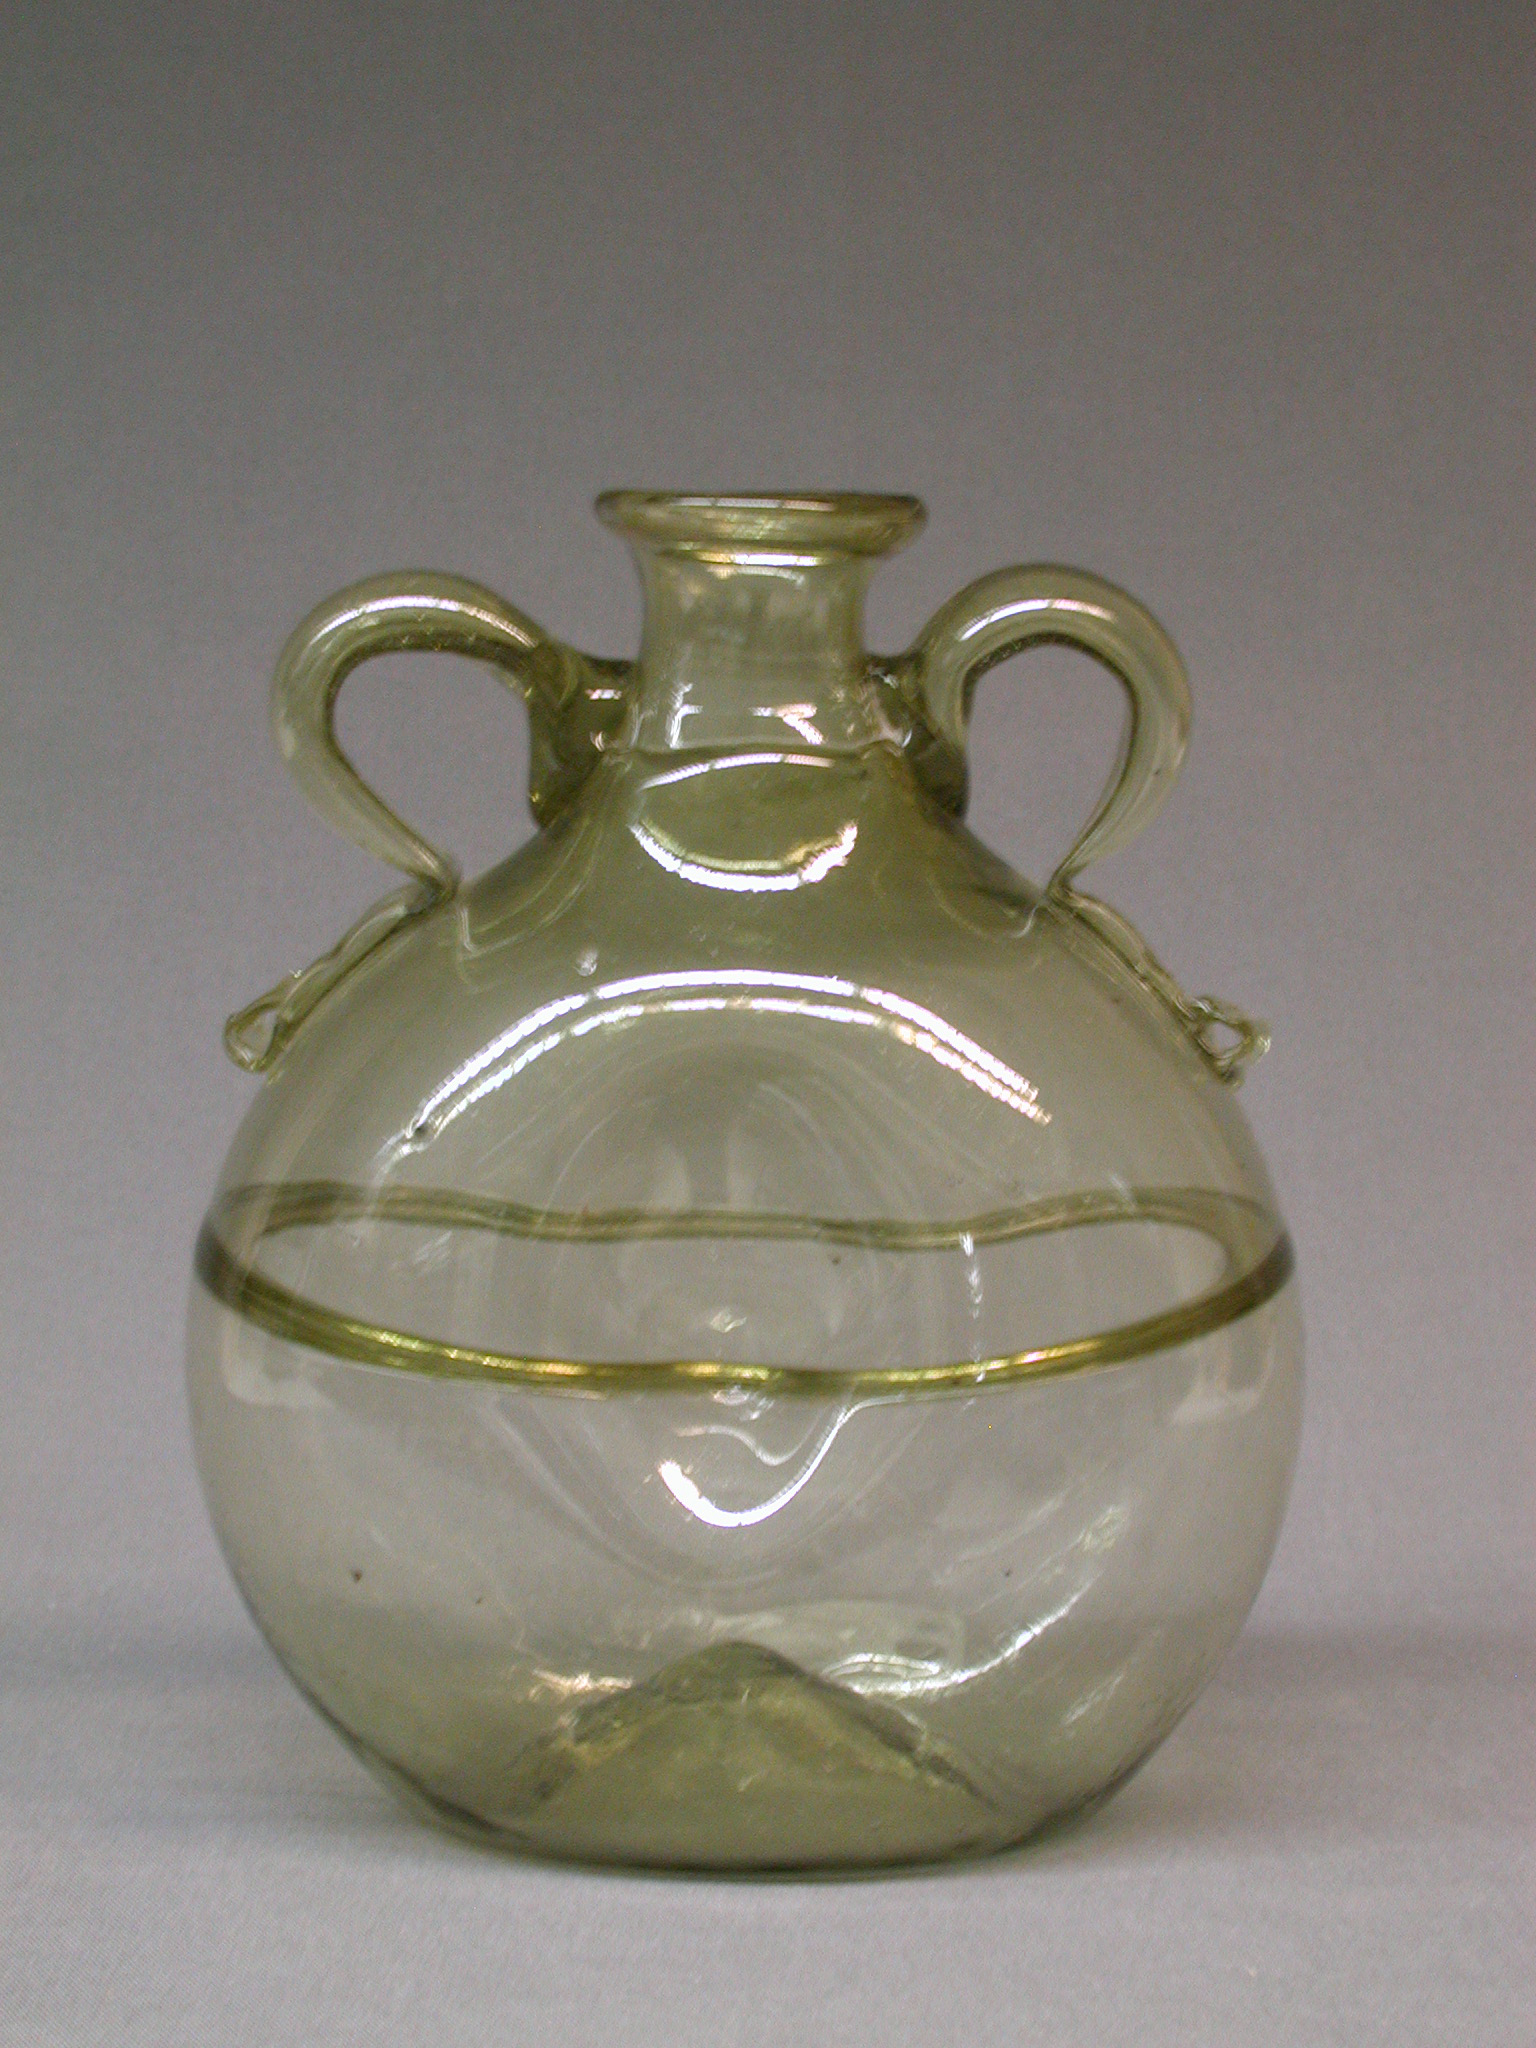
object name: pilgrim bottle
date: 1601-1800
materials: glass